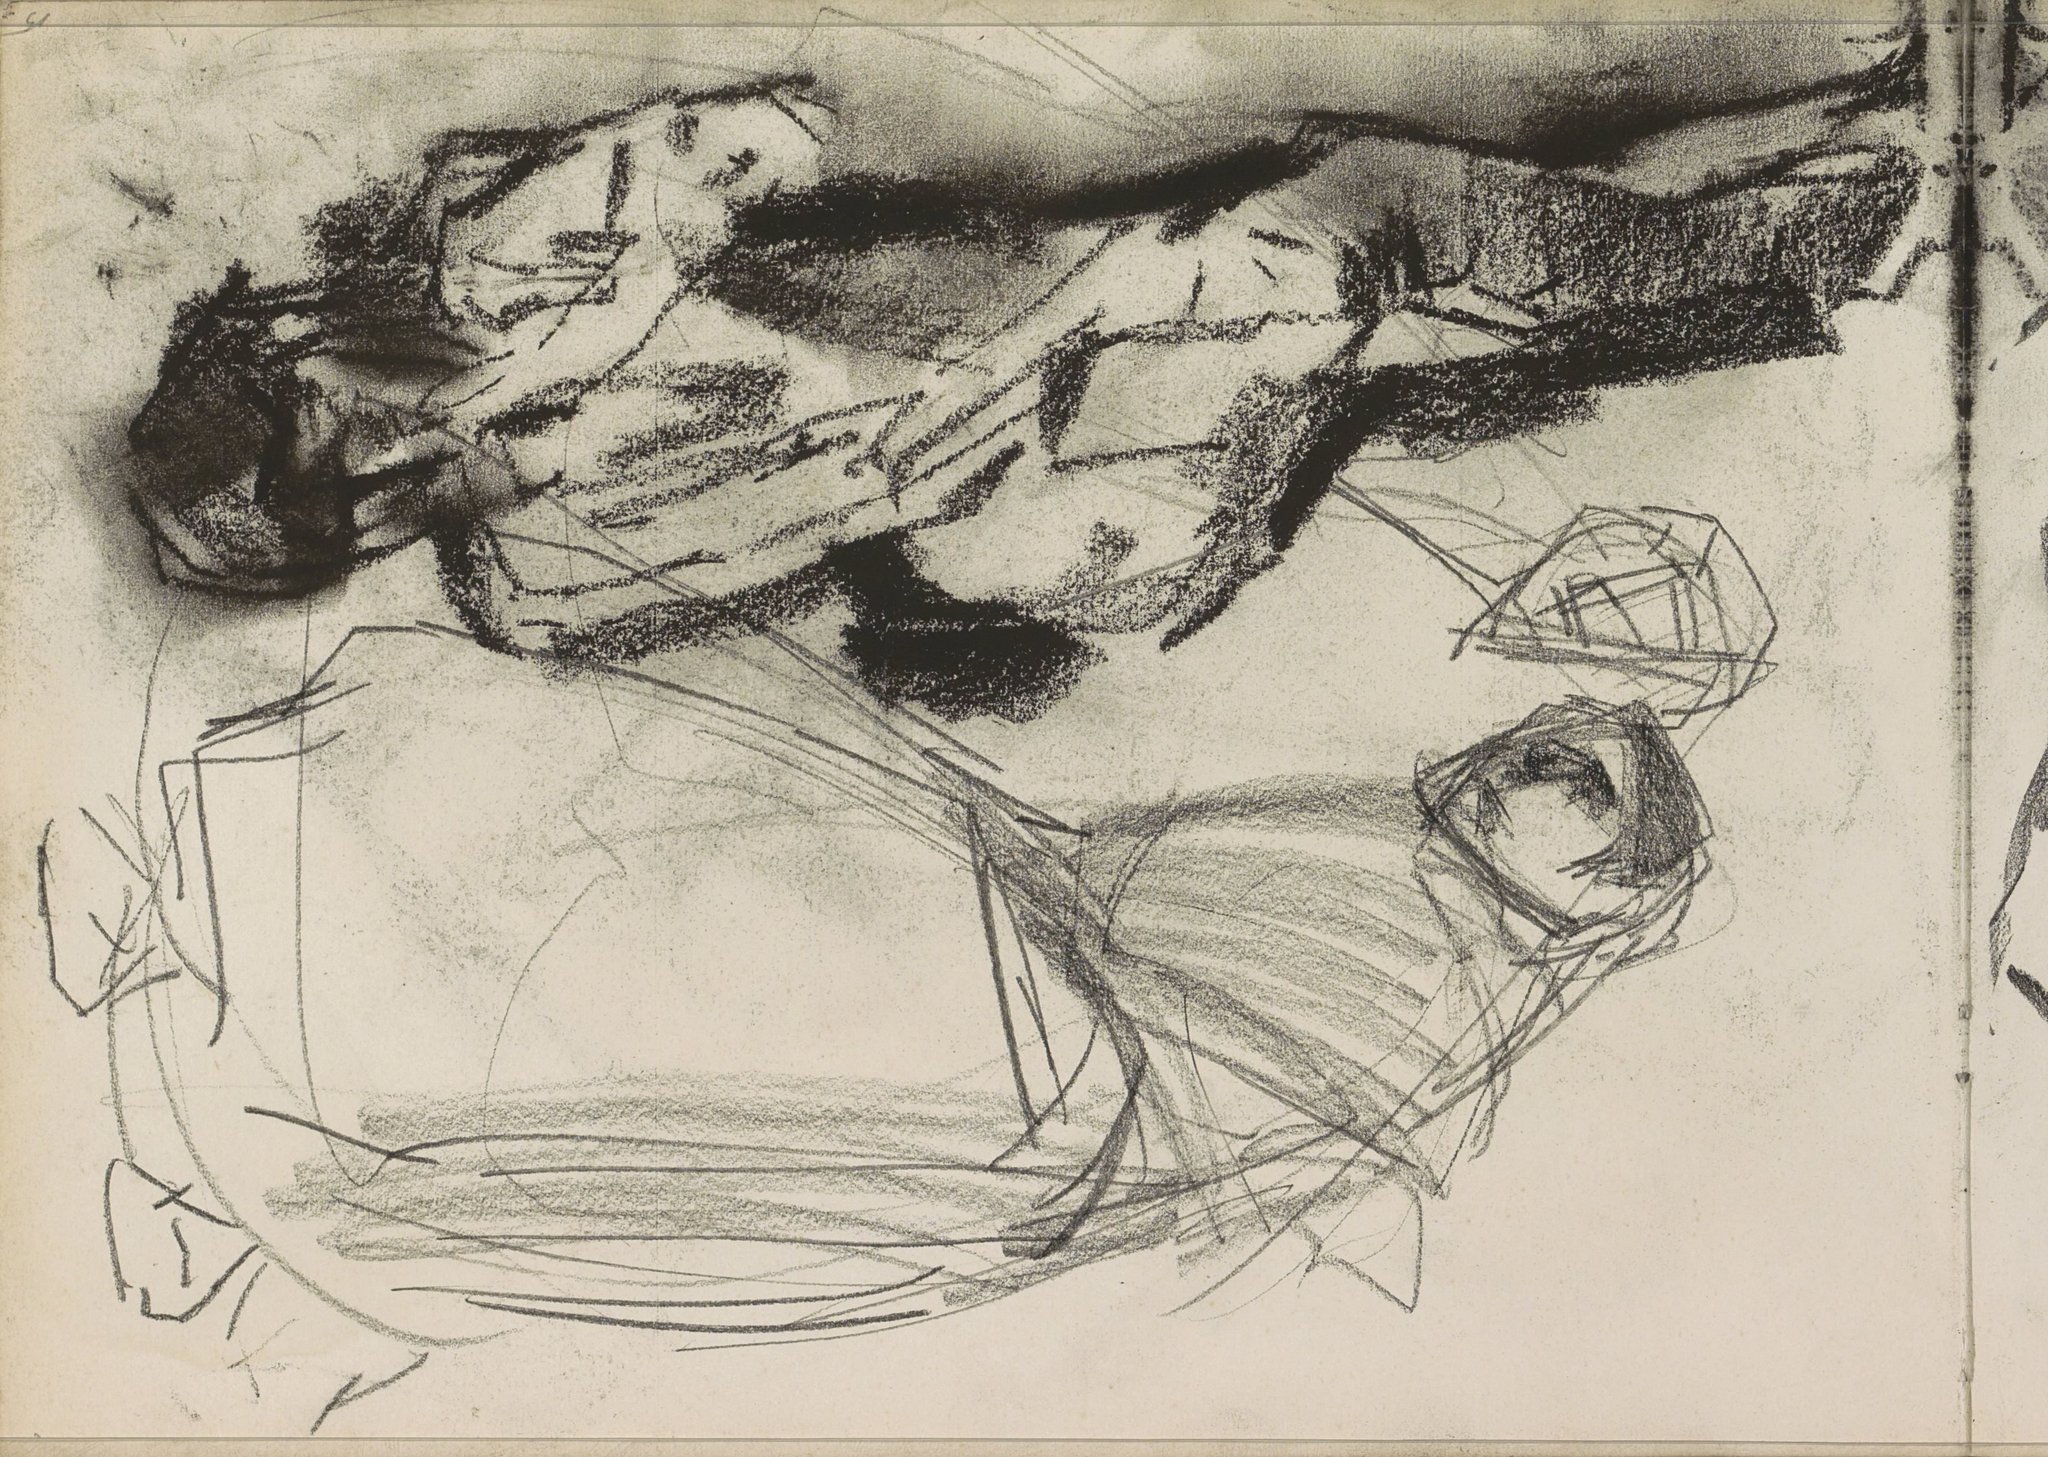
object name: sketchbook leaf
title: Twee staande vrouwen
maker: isaac israels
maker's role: draughtsman, painter, print maker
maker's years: 1865-1934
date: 1892-1900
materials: chalk, paper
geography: the hague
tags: standing figure - aa - female human figure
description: Eén van de vrouwen is naakt. Blad 10 verso uit schetsboek VIII met 12 bladen.